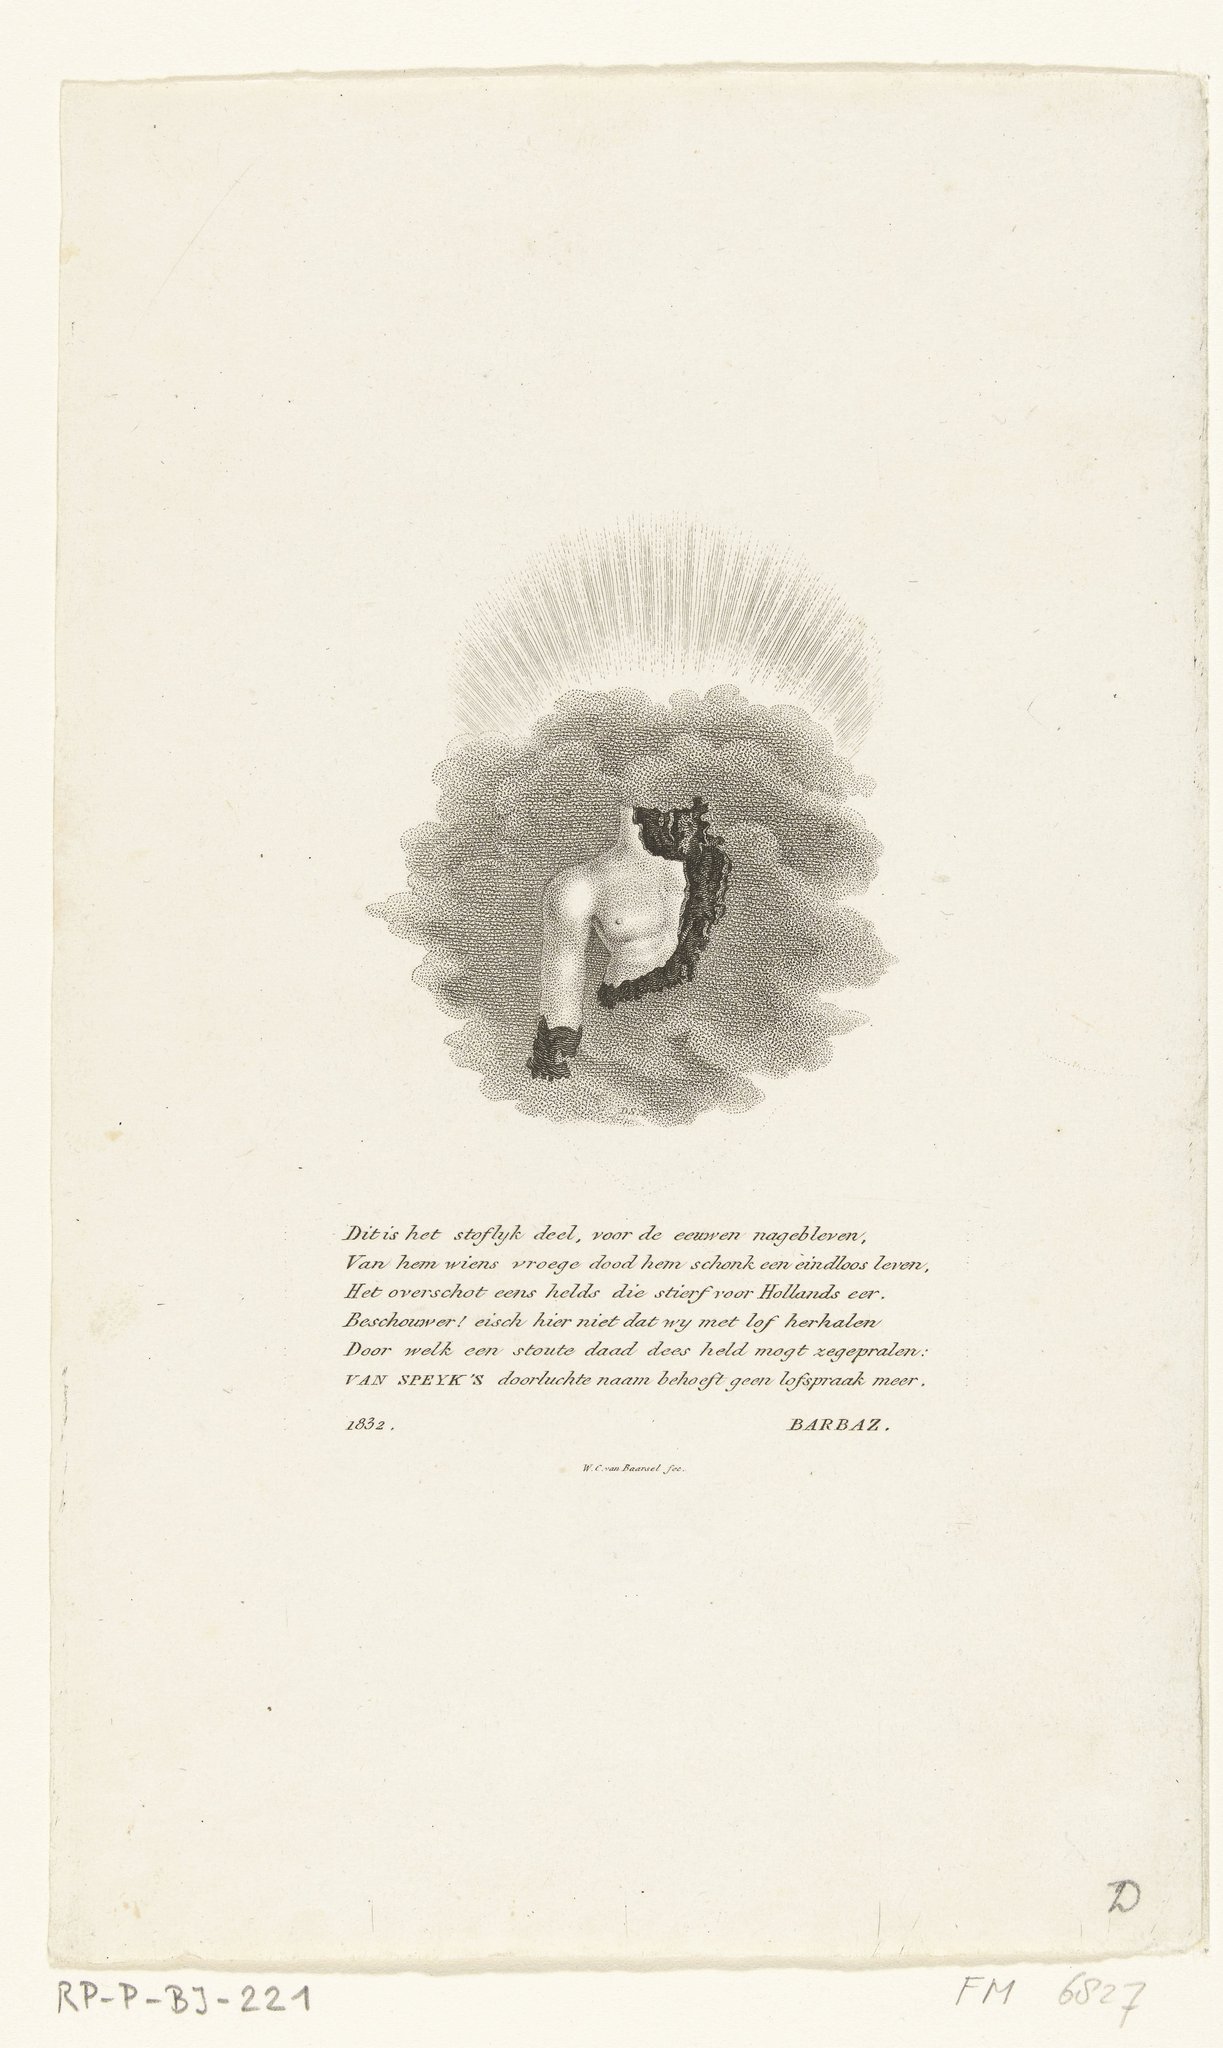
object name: print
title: Overblijfselen van J.C.J. van Speyk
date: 1832-1834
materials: paper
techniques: etching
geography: netherlands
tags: amsterdam, antwerp, jan van speyk, parts of the human body (skeleton excepted)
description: De overblijfselen van het ontplofte lichaam van J.C.J. van Speyk. Rechter schouder, borst en bovenarm, op een wolk met stralenkrans. Onder de afbeelding een vers in zes regels over de heldendaden van Van Speyk door A.L. Barbaz.